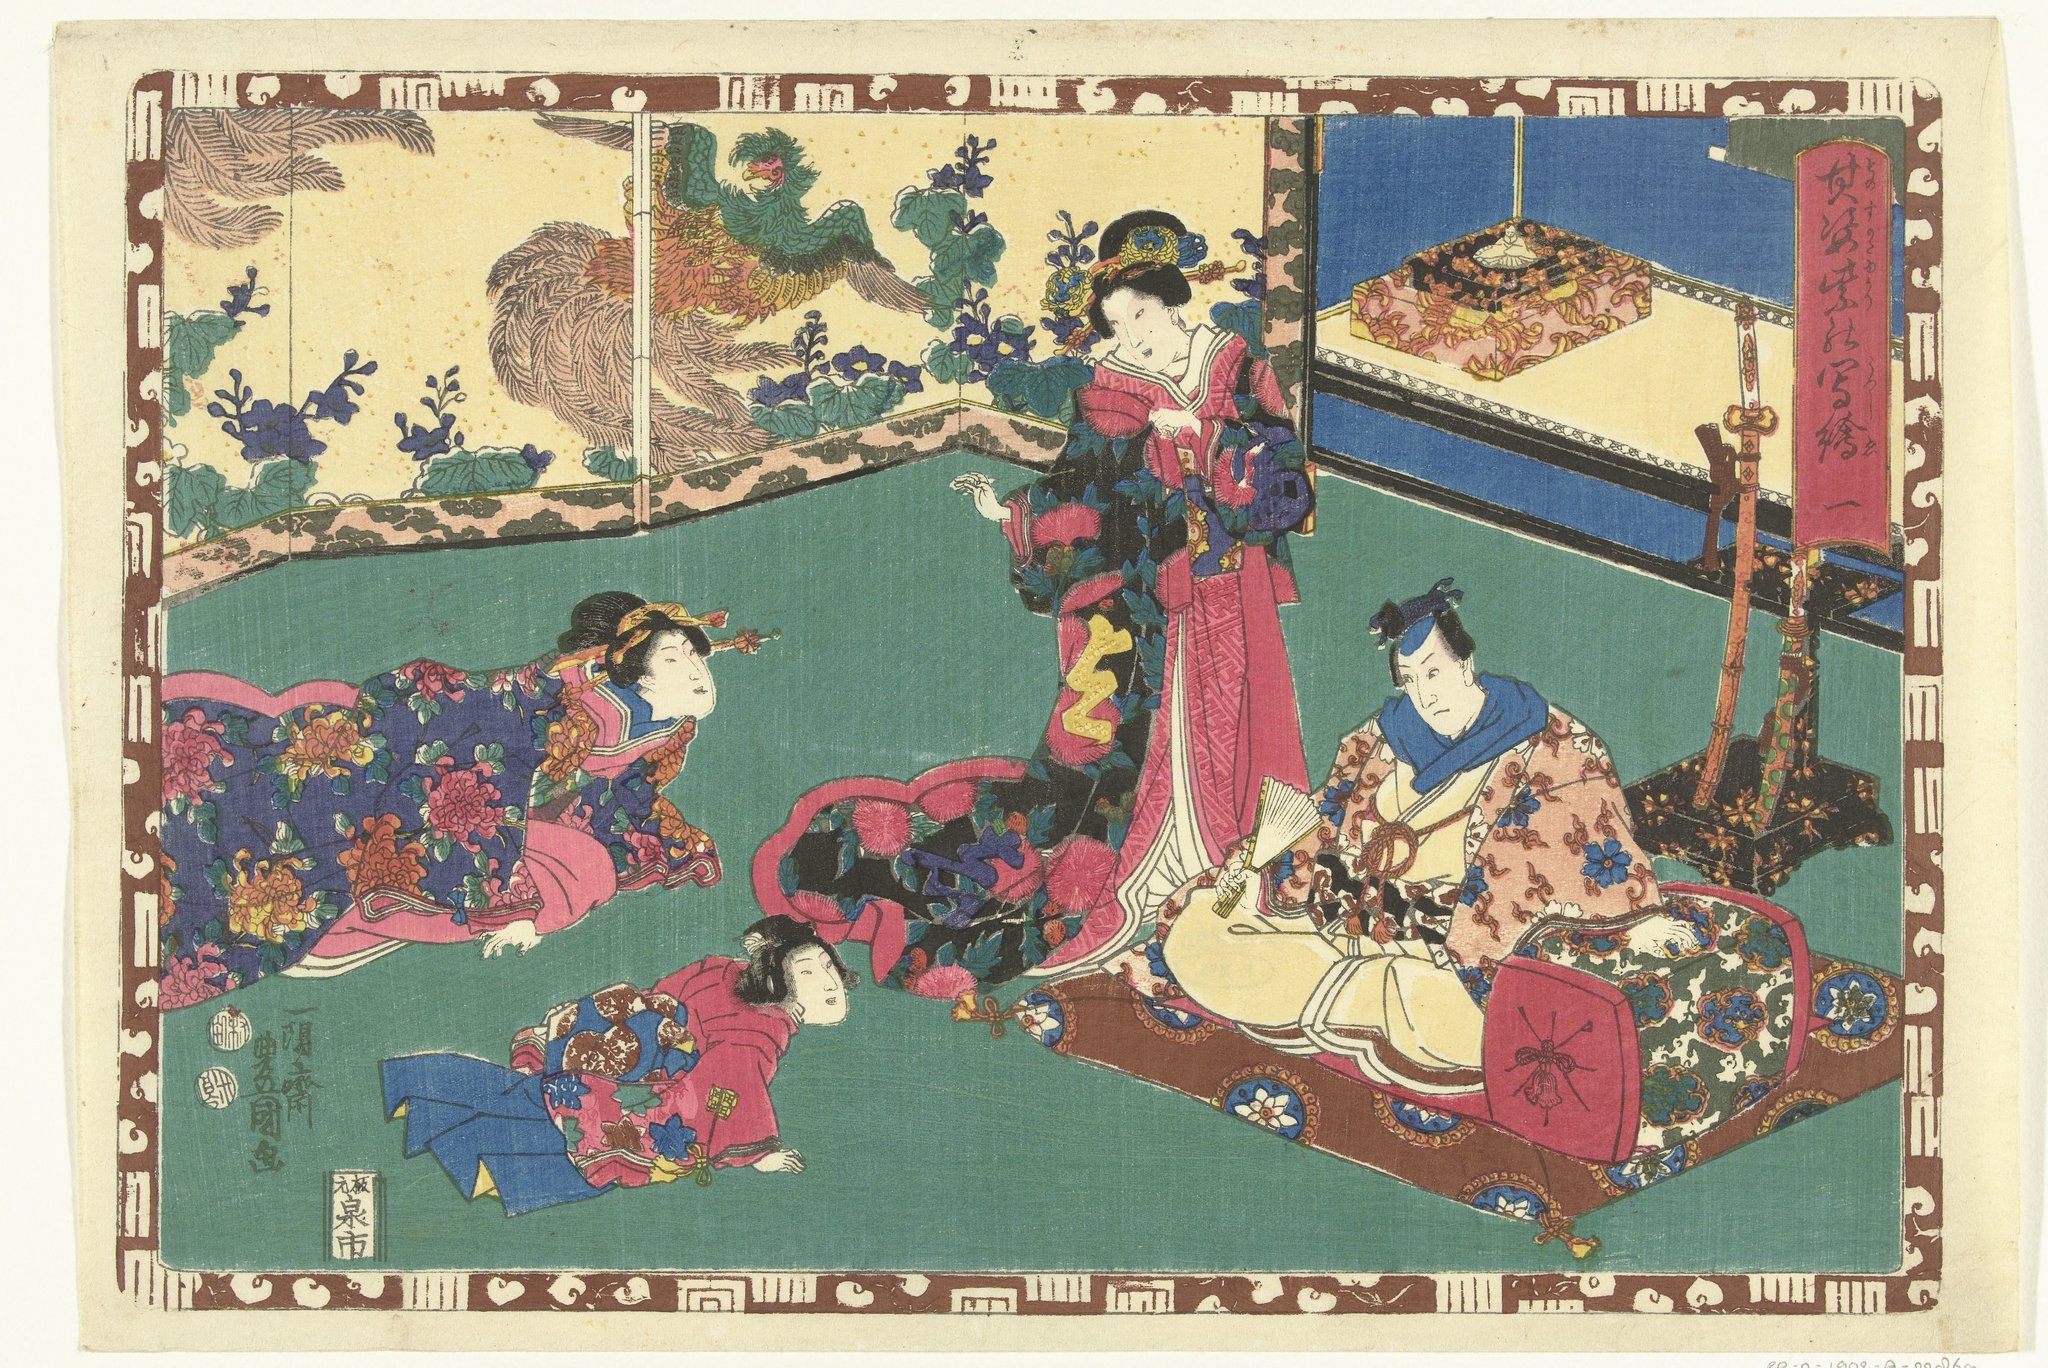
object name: print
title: Sono sugata Hikaru no utsushi-e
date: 1847-1850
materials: paper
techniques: woodcut, nishiki e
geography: tokyo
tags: interior of the house, kneeling before a ruler, screen, folding screen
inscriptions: collector's mark: Lugt 2228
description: Staande vrouw en man zittend op kussen, kijkend naar kielende vrouw en kind. Op de achtergrond een kamerscherm met schildering van een feniks. Voorstelling omsloten door bruine rand waarin Genji emblemen.